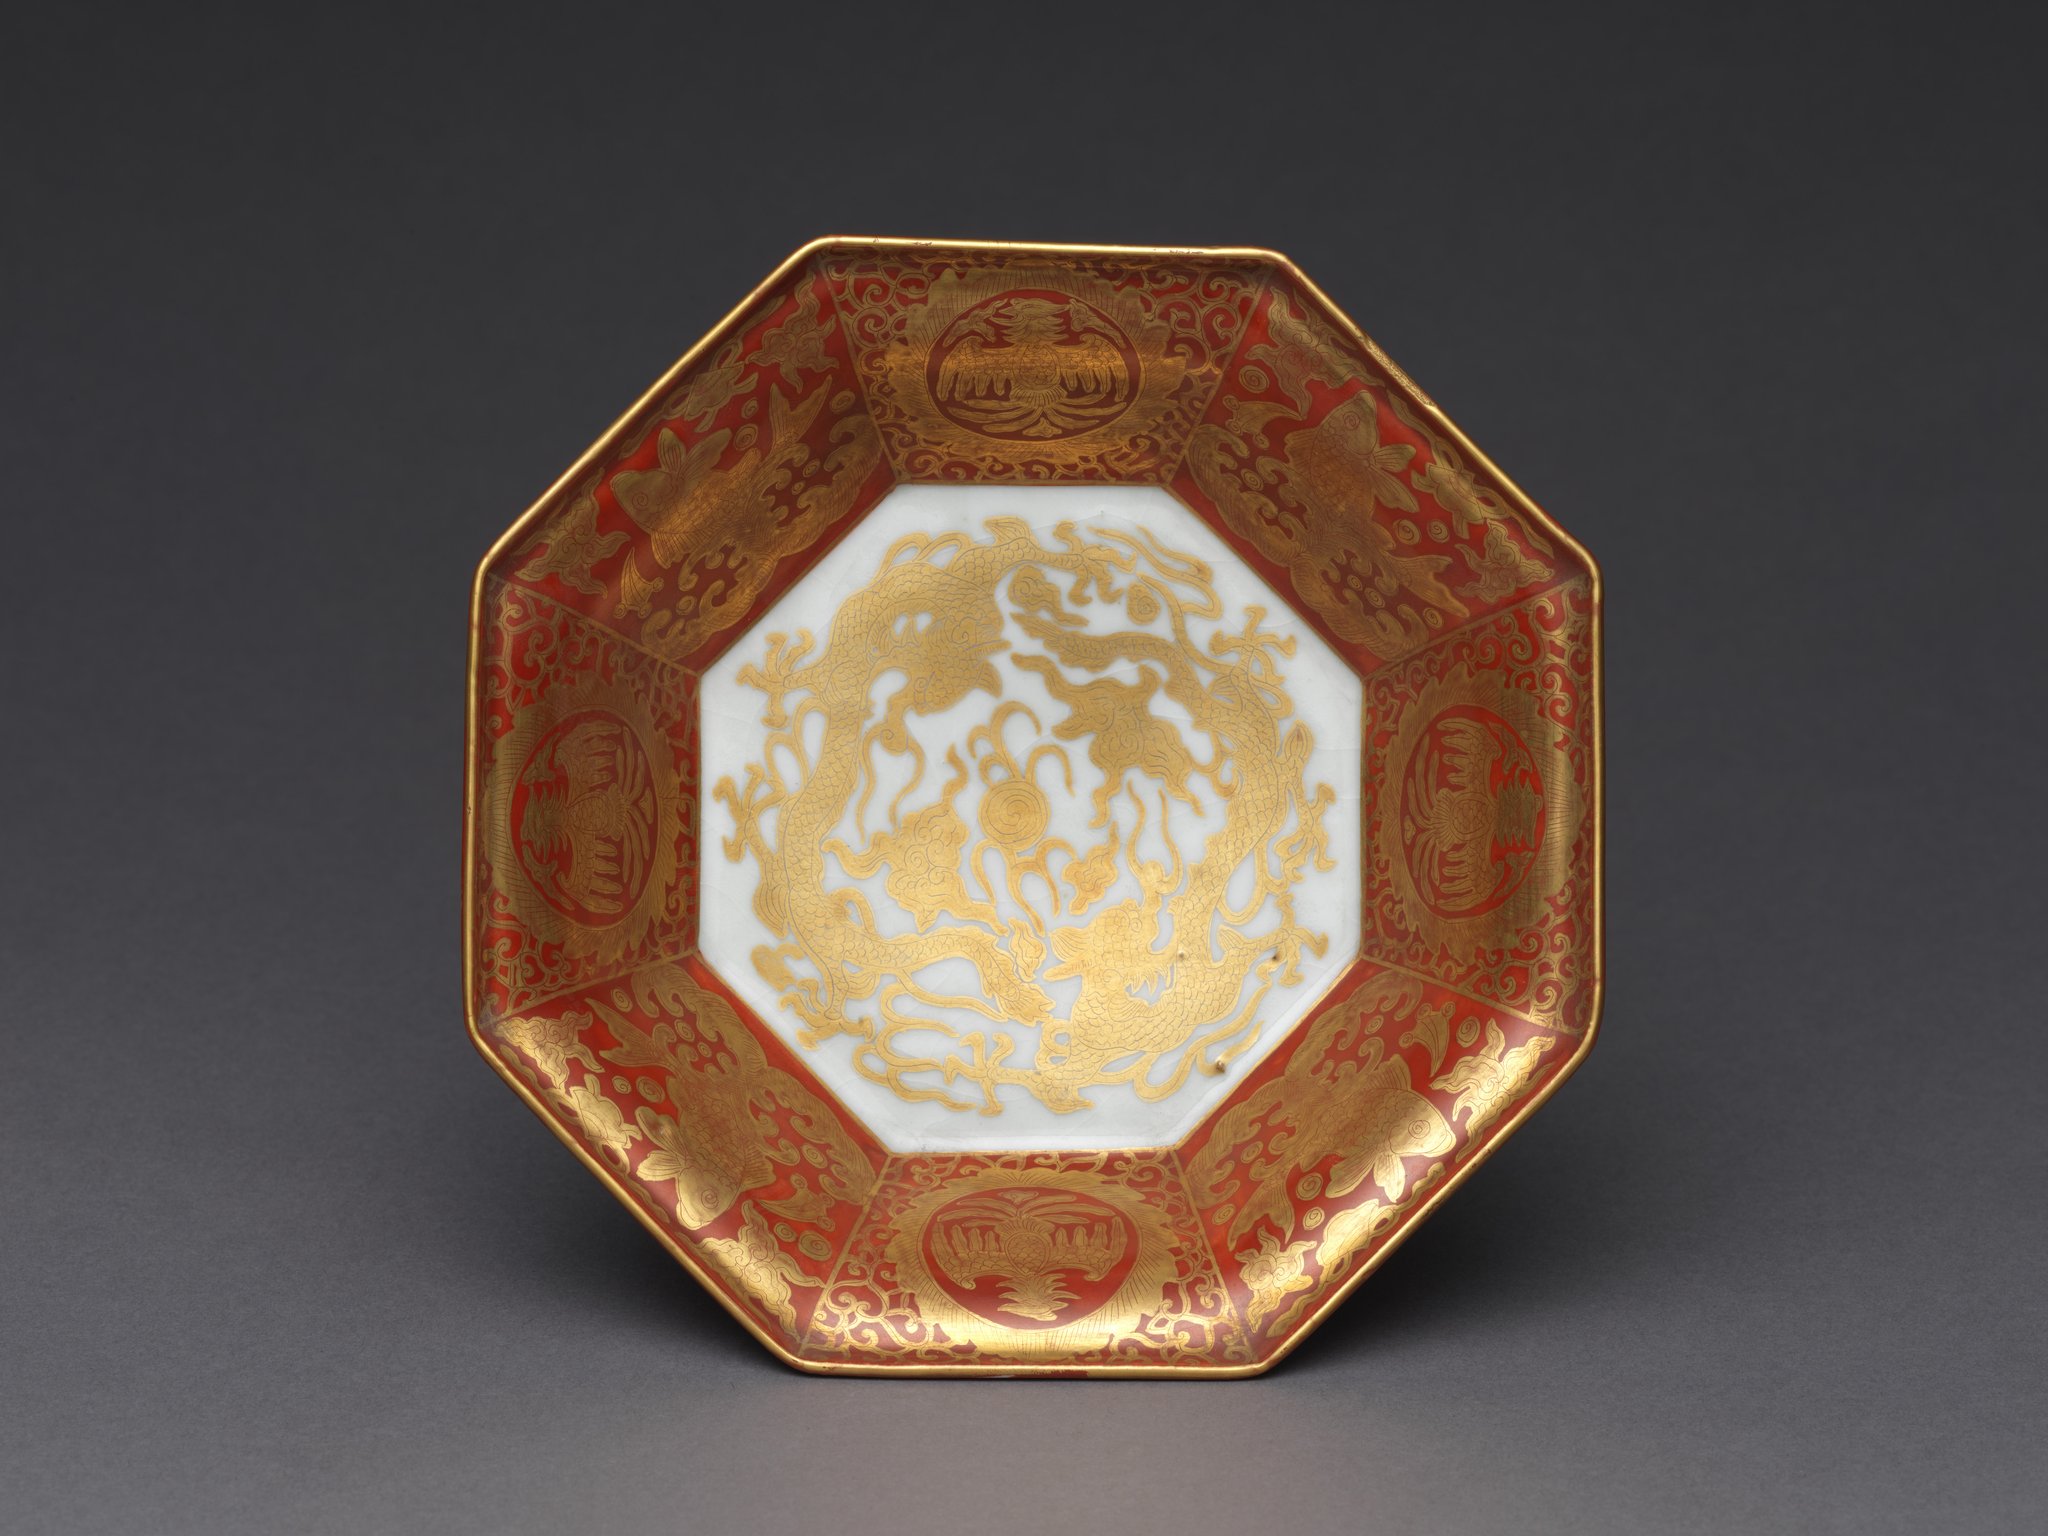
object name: bowl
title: Octagonal Bowl with Dragons and Auspicious Motifs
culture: japanese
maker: eiraku tokuzen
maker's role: artist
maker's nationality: japanese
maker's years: 1853-1909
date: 1851-1900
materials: glaze, gold, porcelain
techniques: painting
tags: dragons